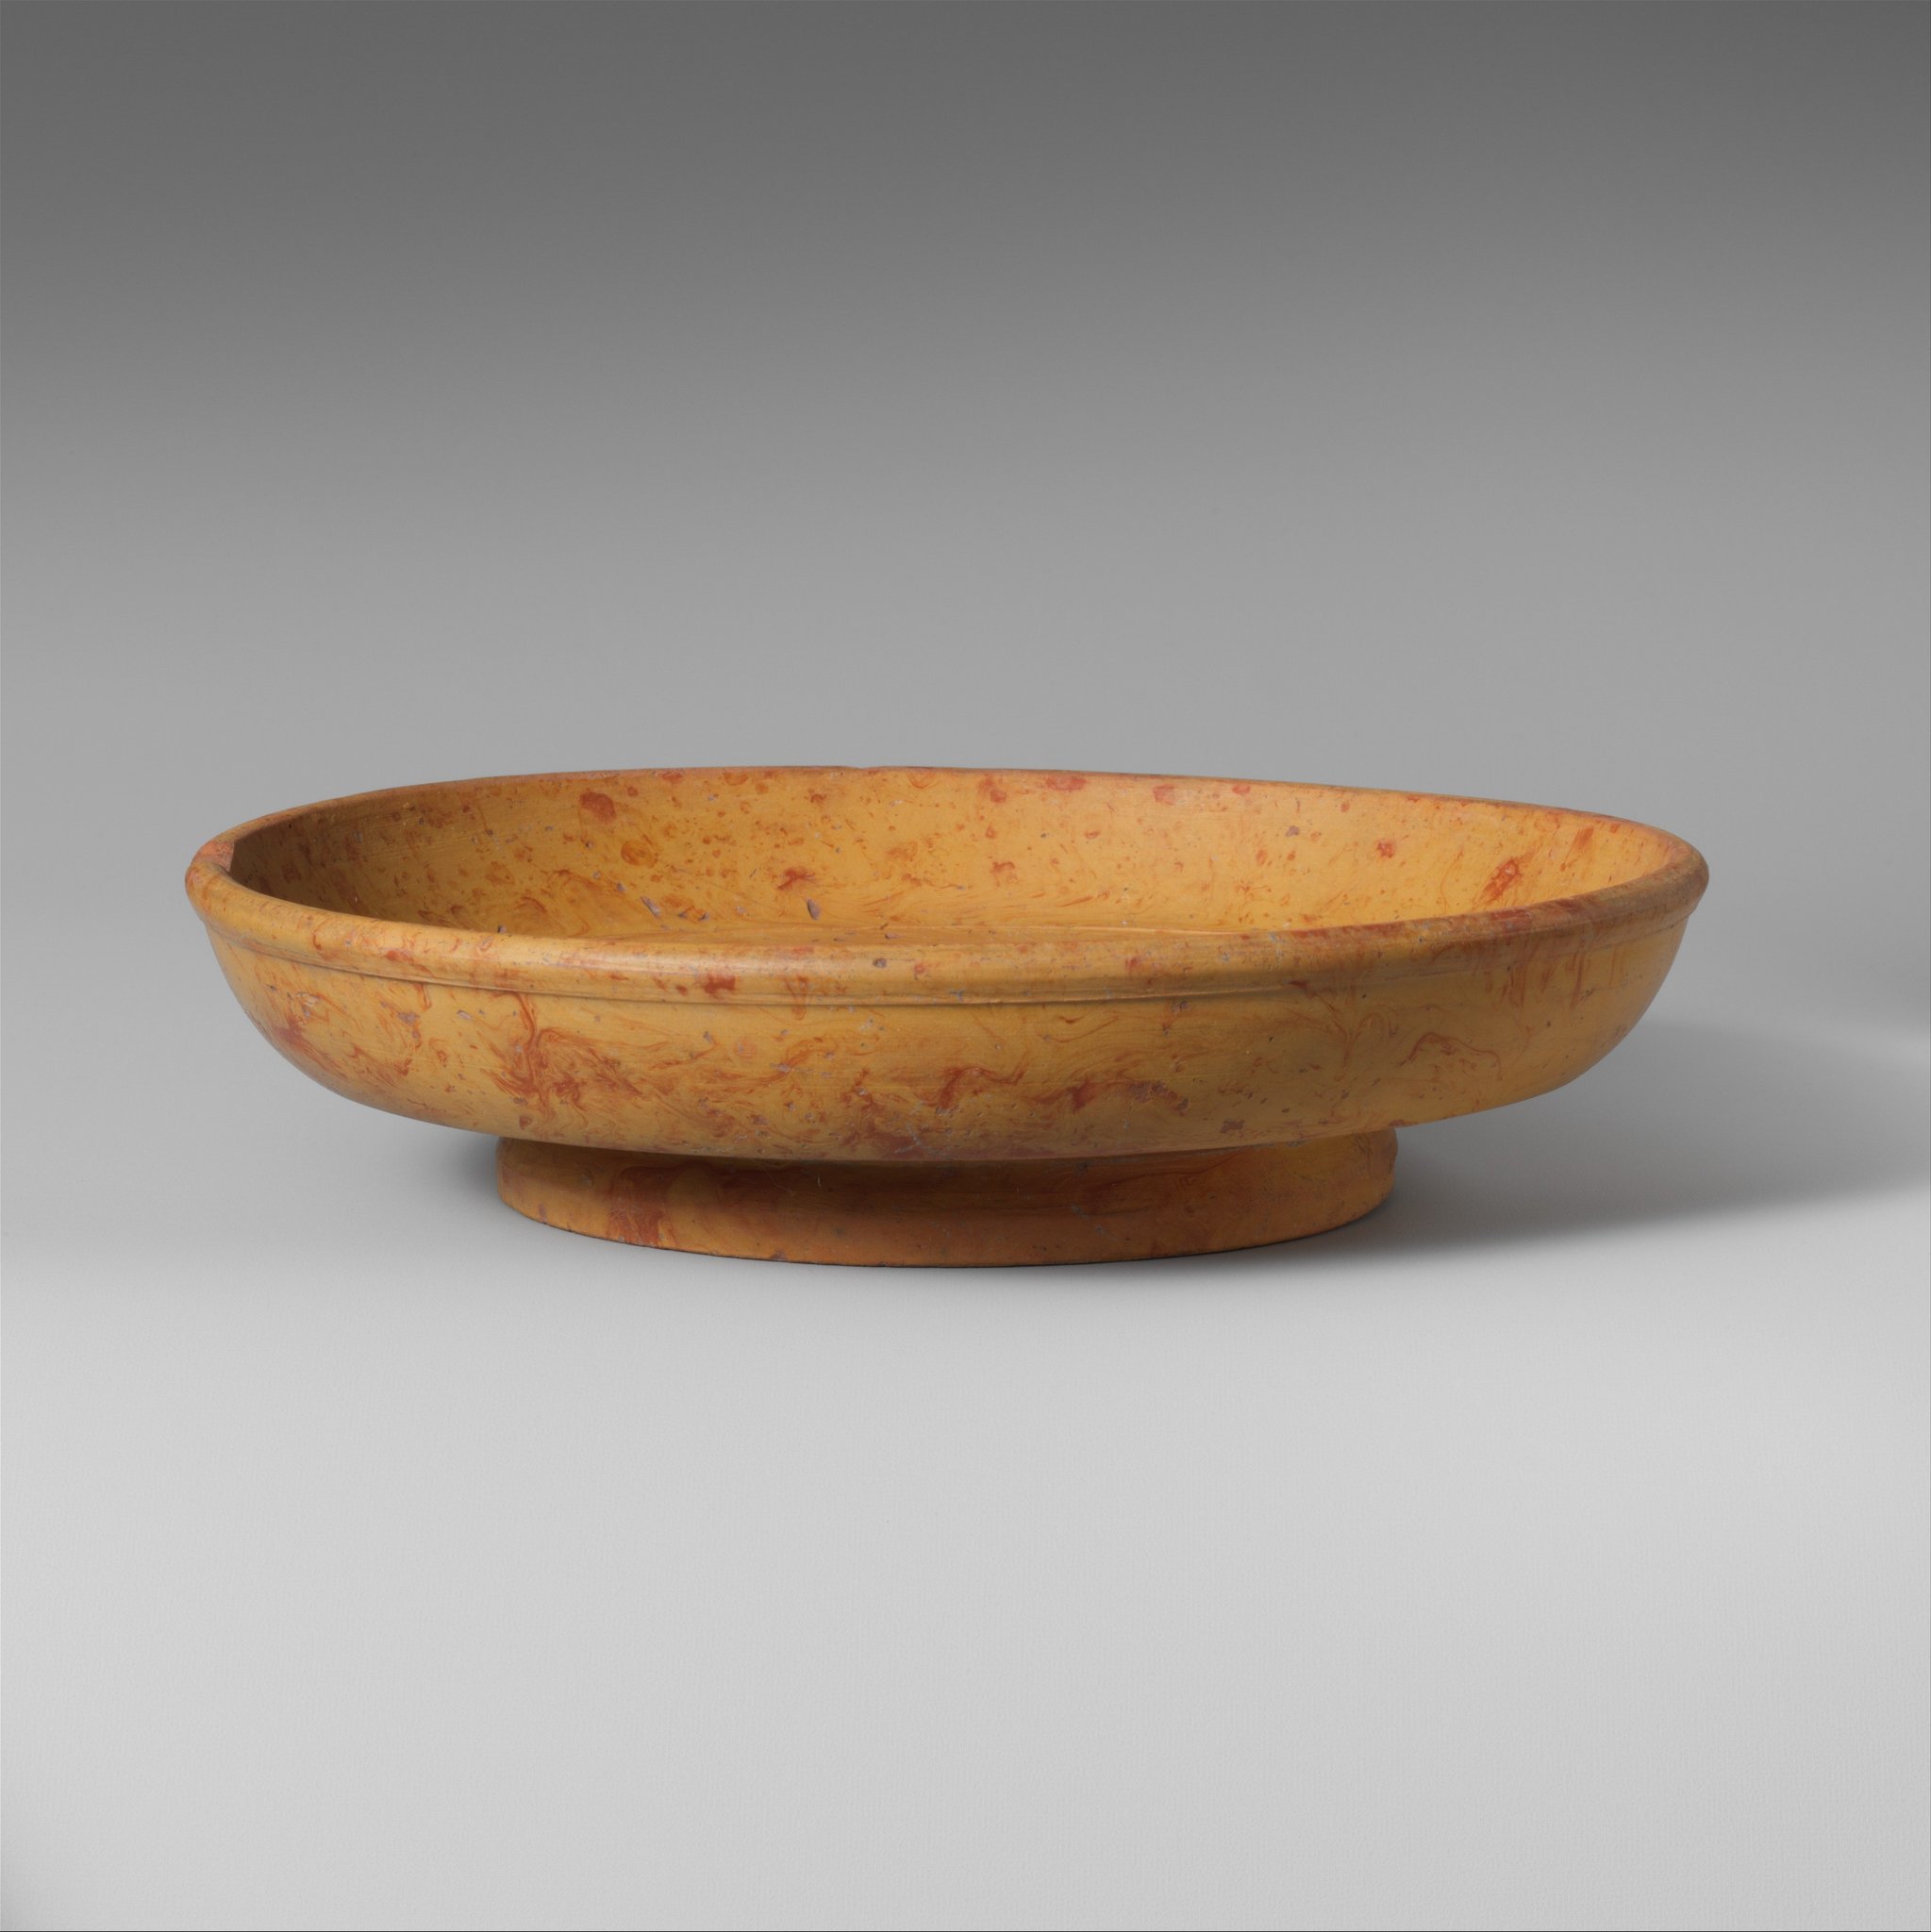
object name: bowl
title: Terracotta marbled slip ware bowl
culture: roman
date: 34-66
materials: terracotta